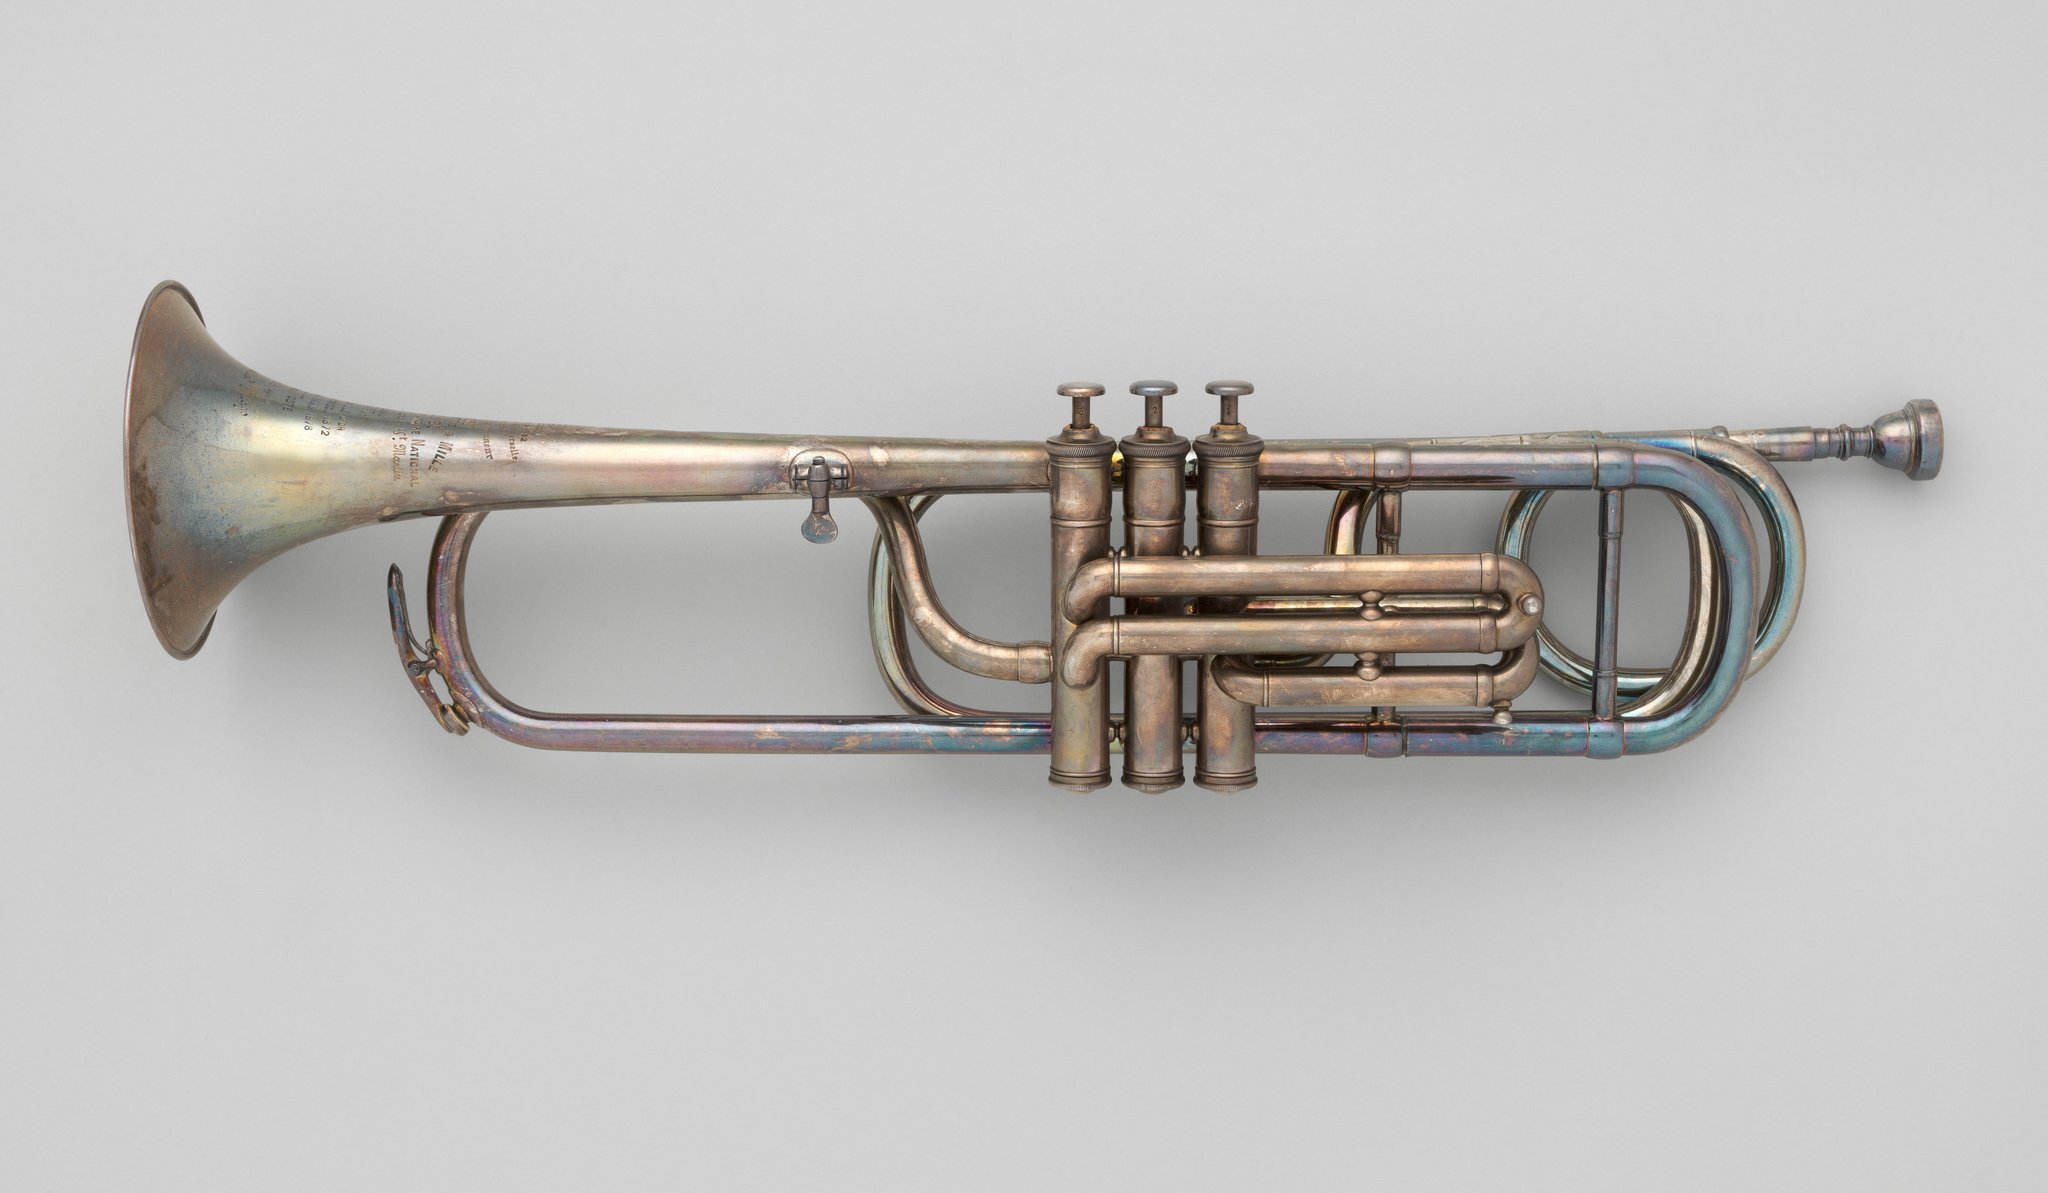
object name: valve trumpet in f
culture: french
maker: courtois & mille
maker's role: maker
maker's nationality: french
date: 1881-1885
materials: brass, silver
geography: france